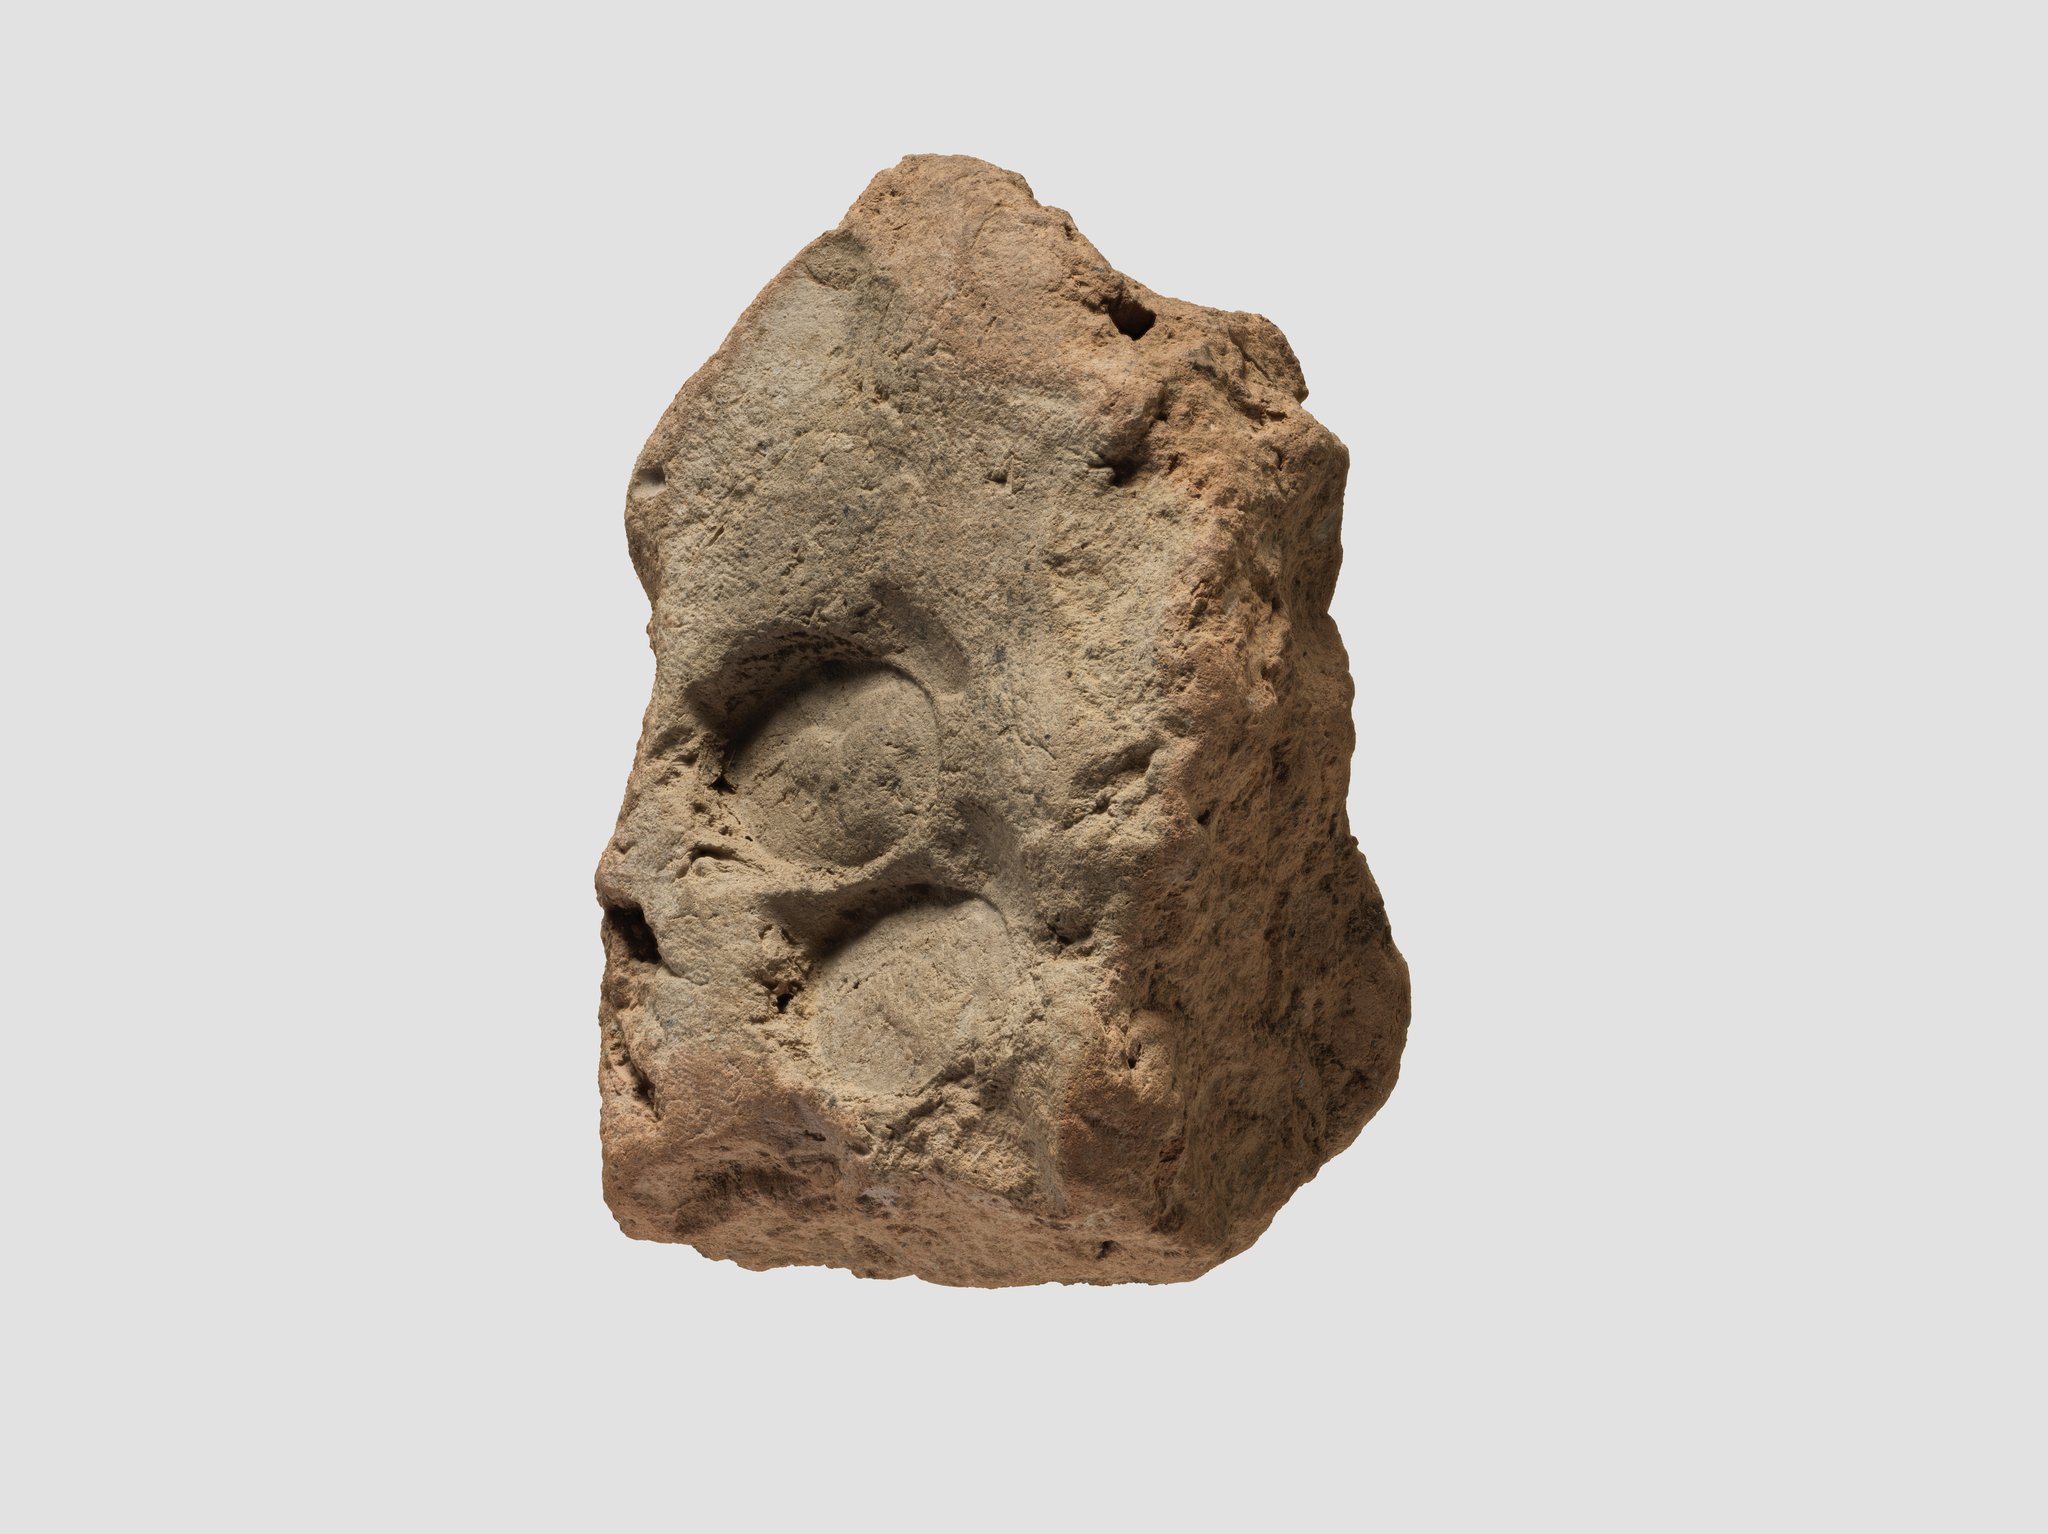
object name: bulla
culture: parthian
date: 200 BCE-100 CE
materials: clay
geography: iran